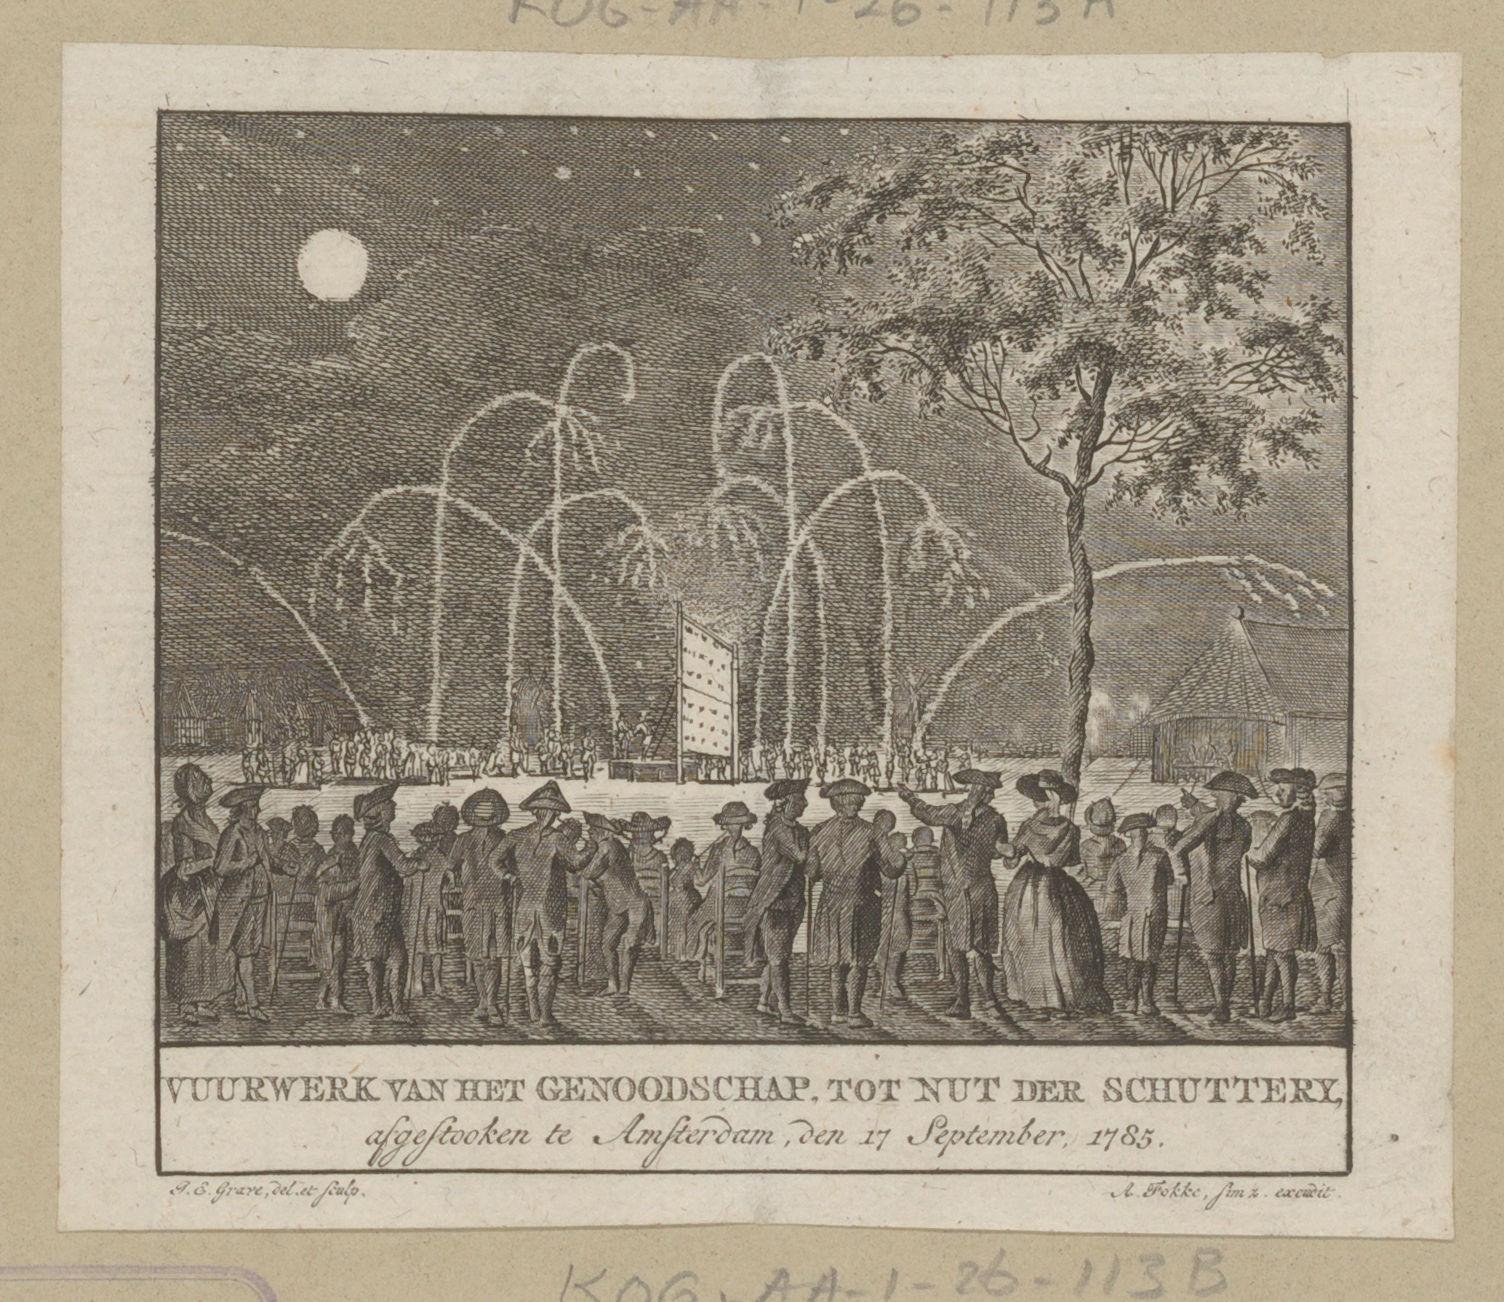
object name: print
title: Toeschouwers bij vuurwerk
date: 1783-1788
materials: paper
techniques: engraving, etching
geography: amsterdam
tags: crowd, mob, bonfire, fire-works, amsterdam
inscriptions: collector's mark: Lugt 1641b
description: Prent mogelijk uit: Fokke Simonsz., Arend. De vaderlandsche historie in themata (...). Amsterdam: Arend Simonsz. Fokke, 1783. Of uit latere editie van 1788.